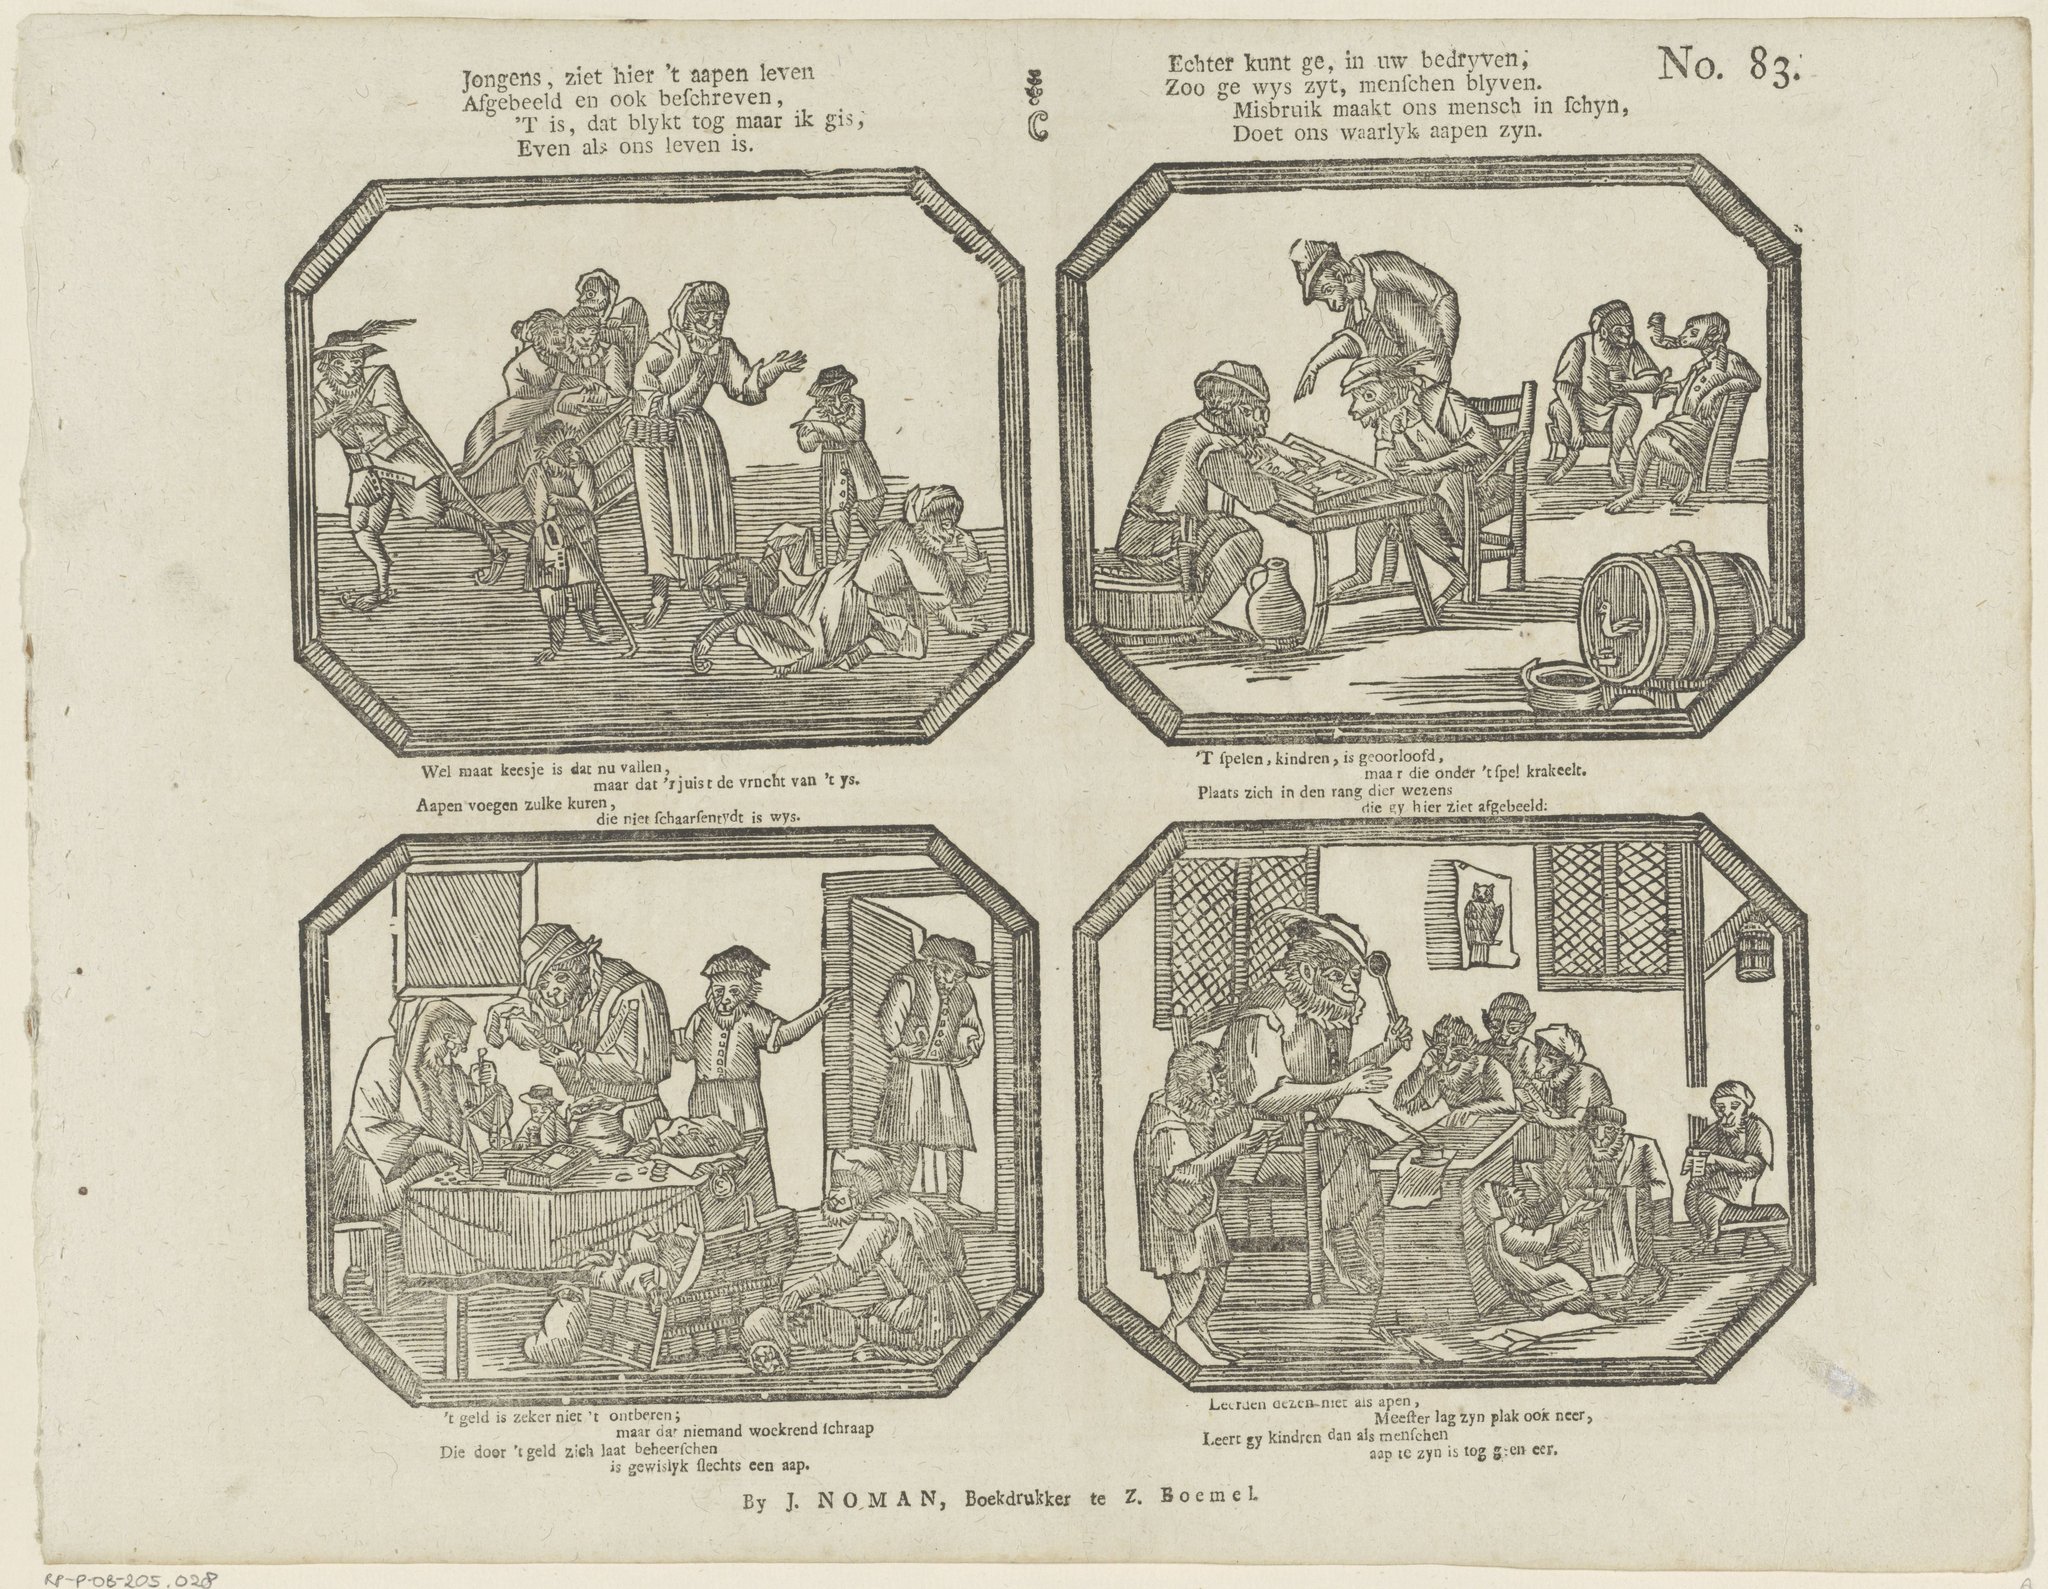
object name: print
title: Jongens, ziet hier 't aapen leven / Afgebeeld en ook beschreven [(...)]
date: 1806-1830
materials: paper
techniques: letterpress printing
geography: zaltbommel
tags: monkeys, apes, animals acting as human beings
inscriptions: collector's mark: Lugt 2760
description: Blad met 4 voorstellingen apen die zich gedragen als mensen. Onder elke afbeelding een vierregelig vers. Genummerd rechtsboven: No. 83.